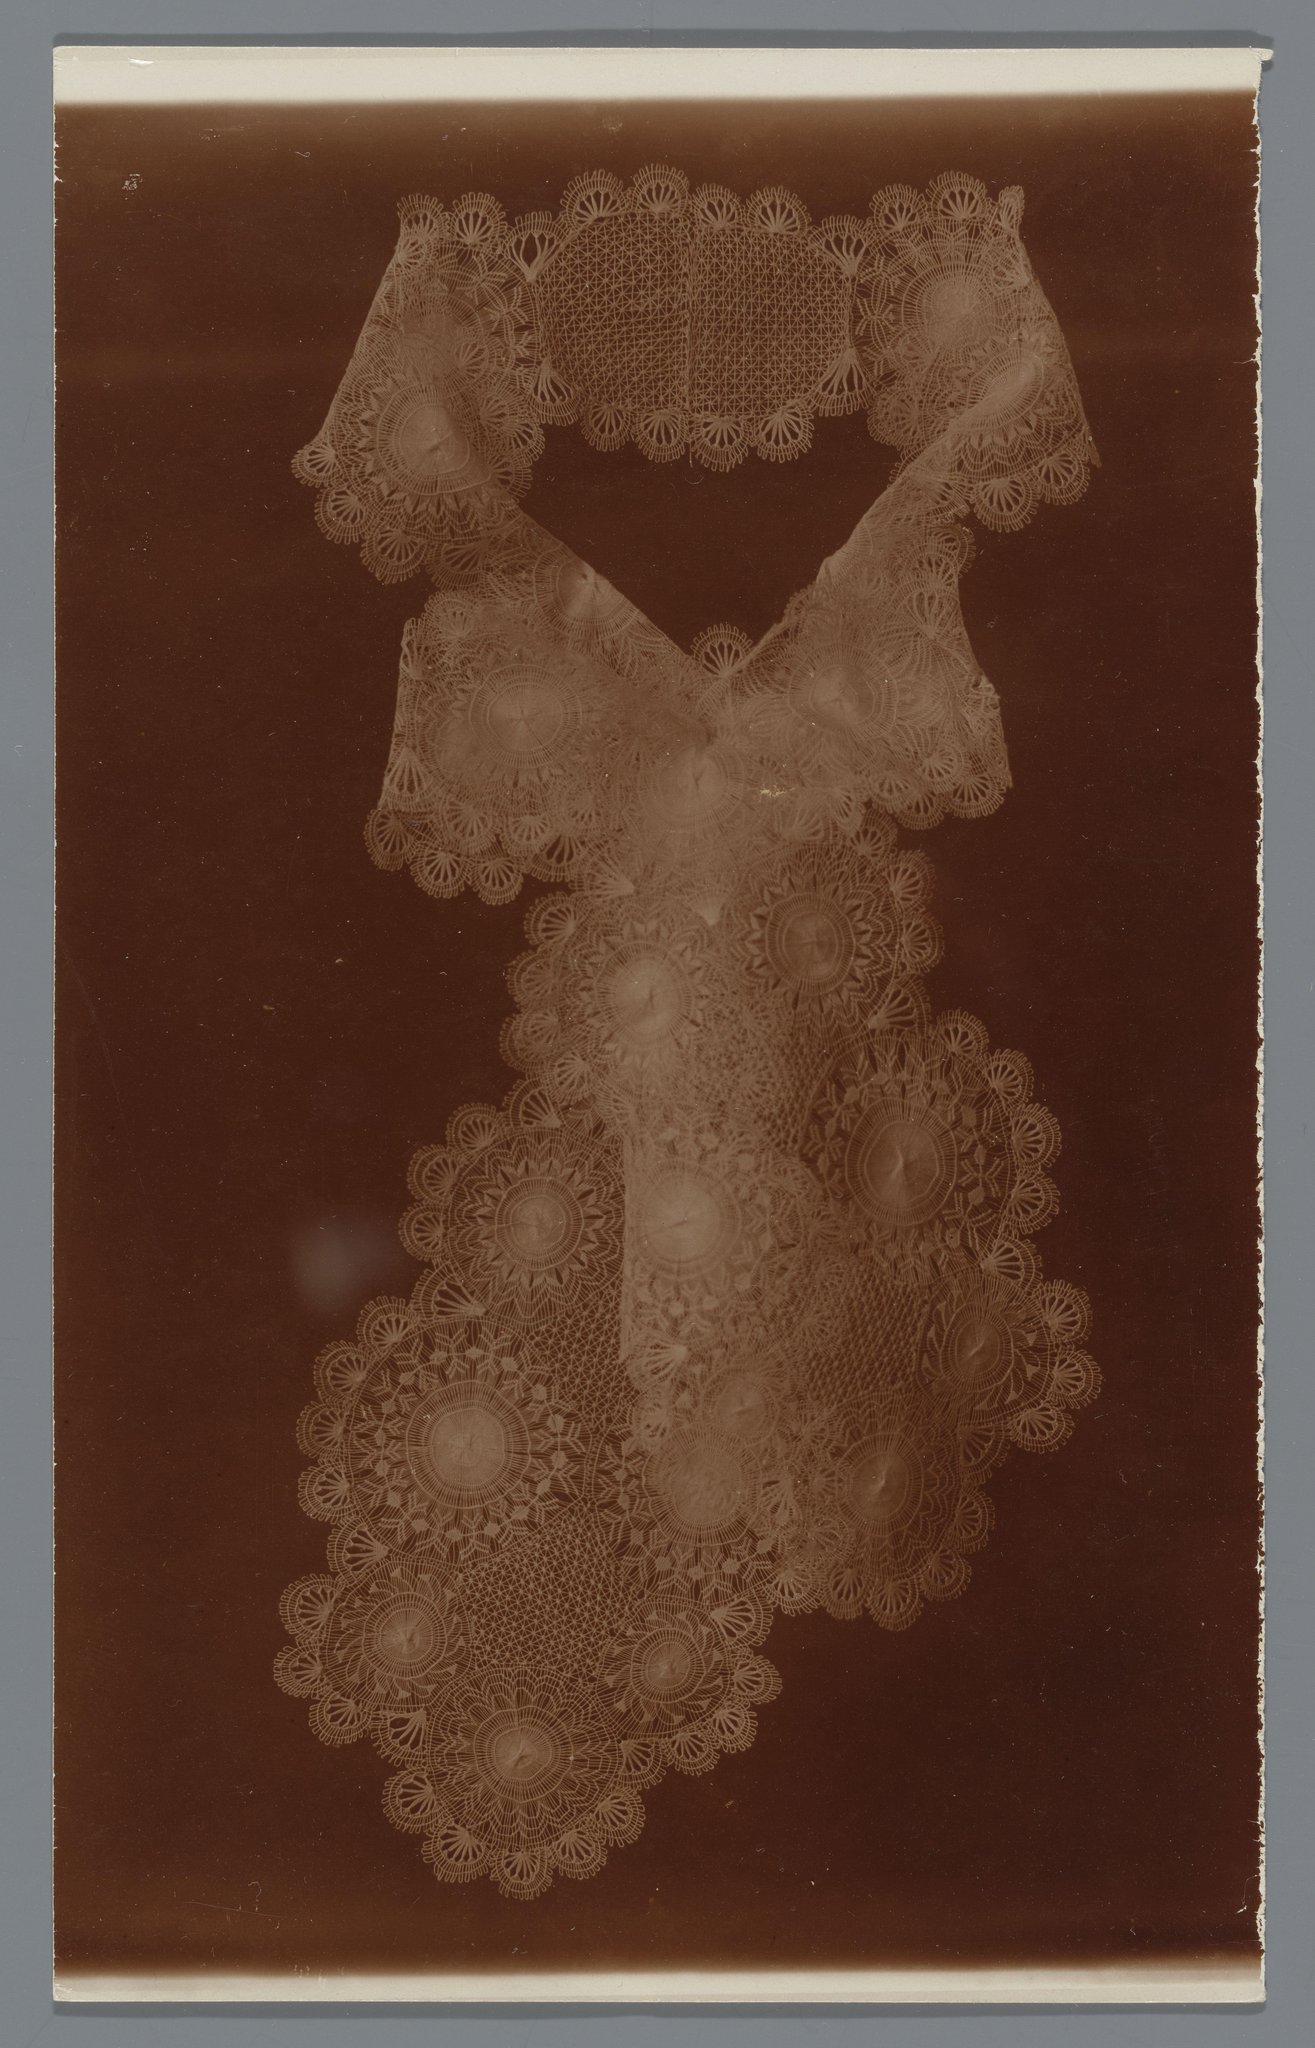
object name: photograph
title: Mutsenslip van kant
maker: Anonymous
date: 1890-1920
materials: paper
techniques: gelatin silver print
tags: lace